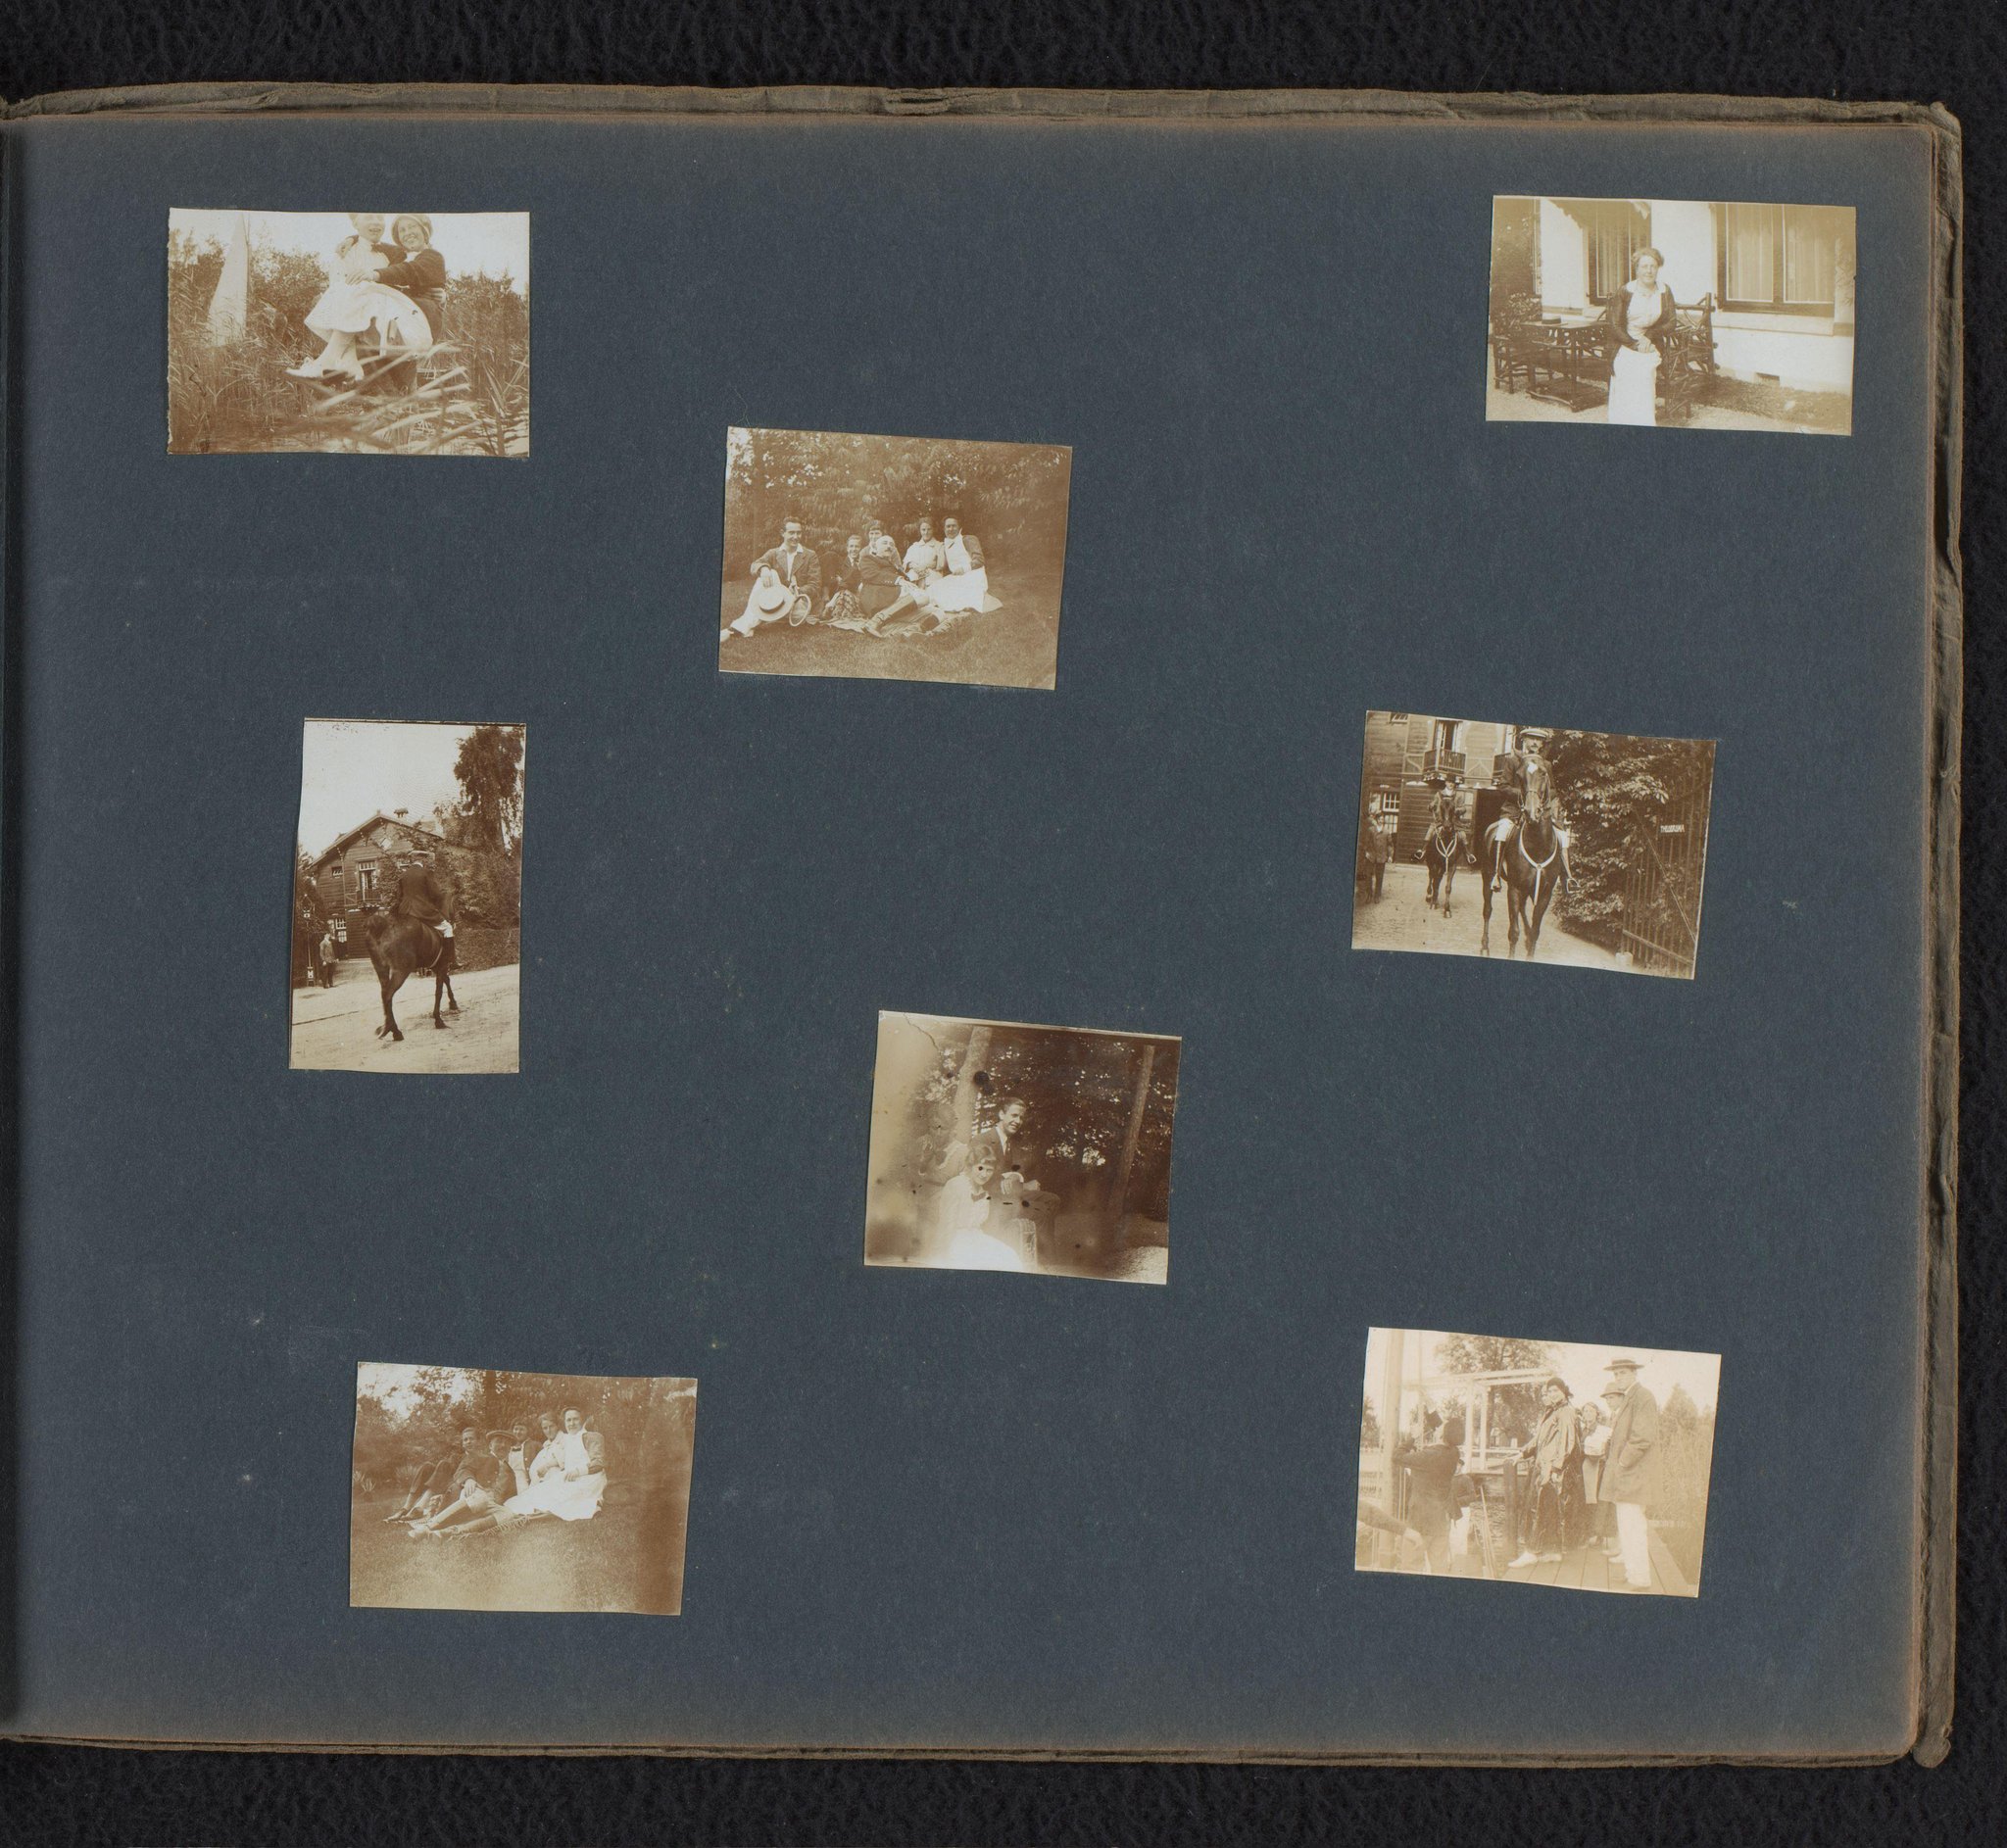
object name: photograph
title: Vriendengroep tijdens een vaartocht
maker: Anonymous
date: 1913-1914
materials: paper, cardboard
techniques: gelatin silver print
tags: sailing-ship, sailing-boat, friends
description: Deze foto's zijn onderdeel van een album.